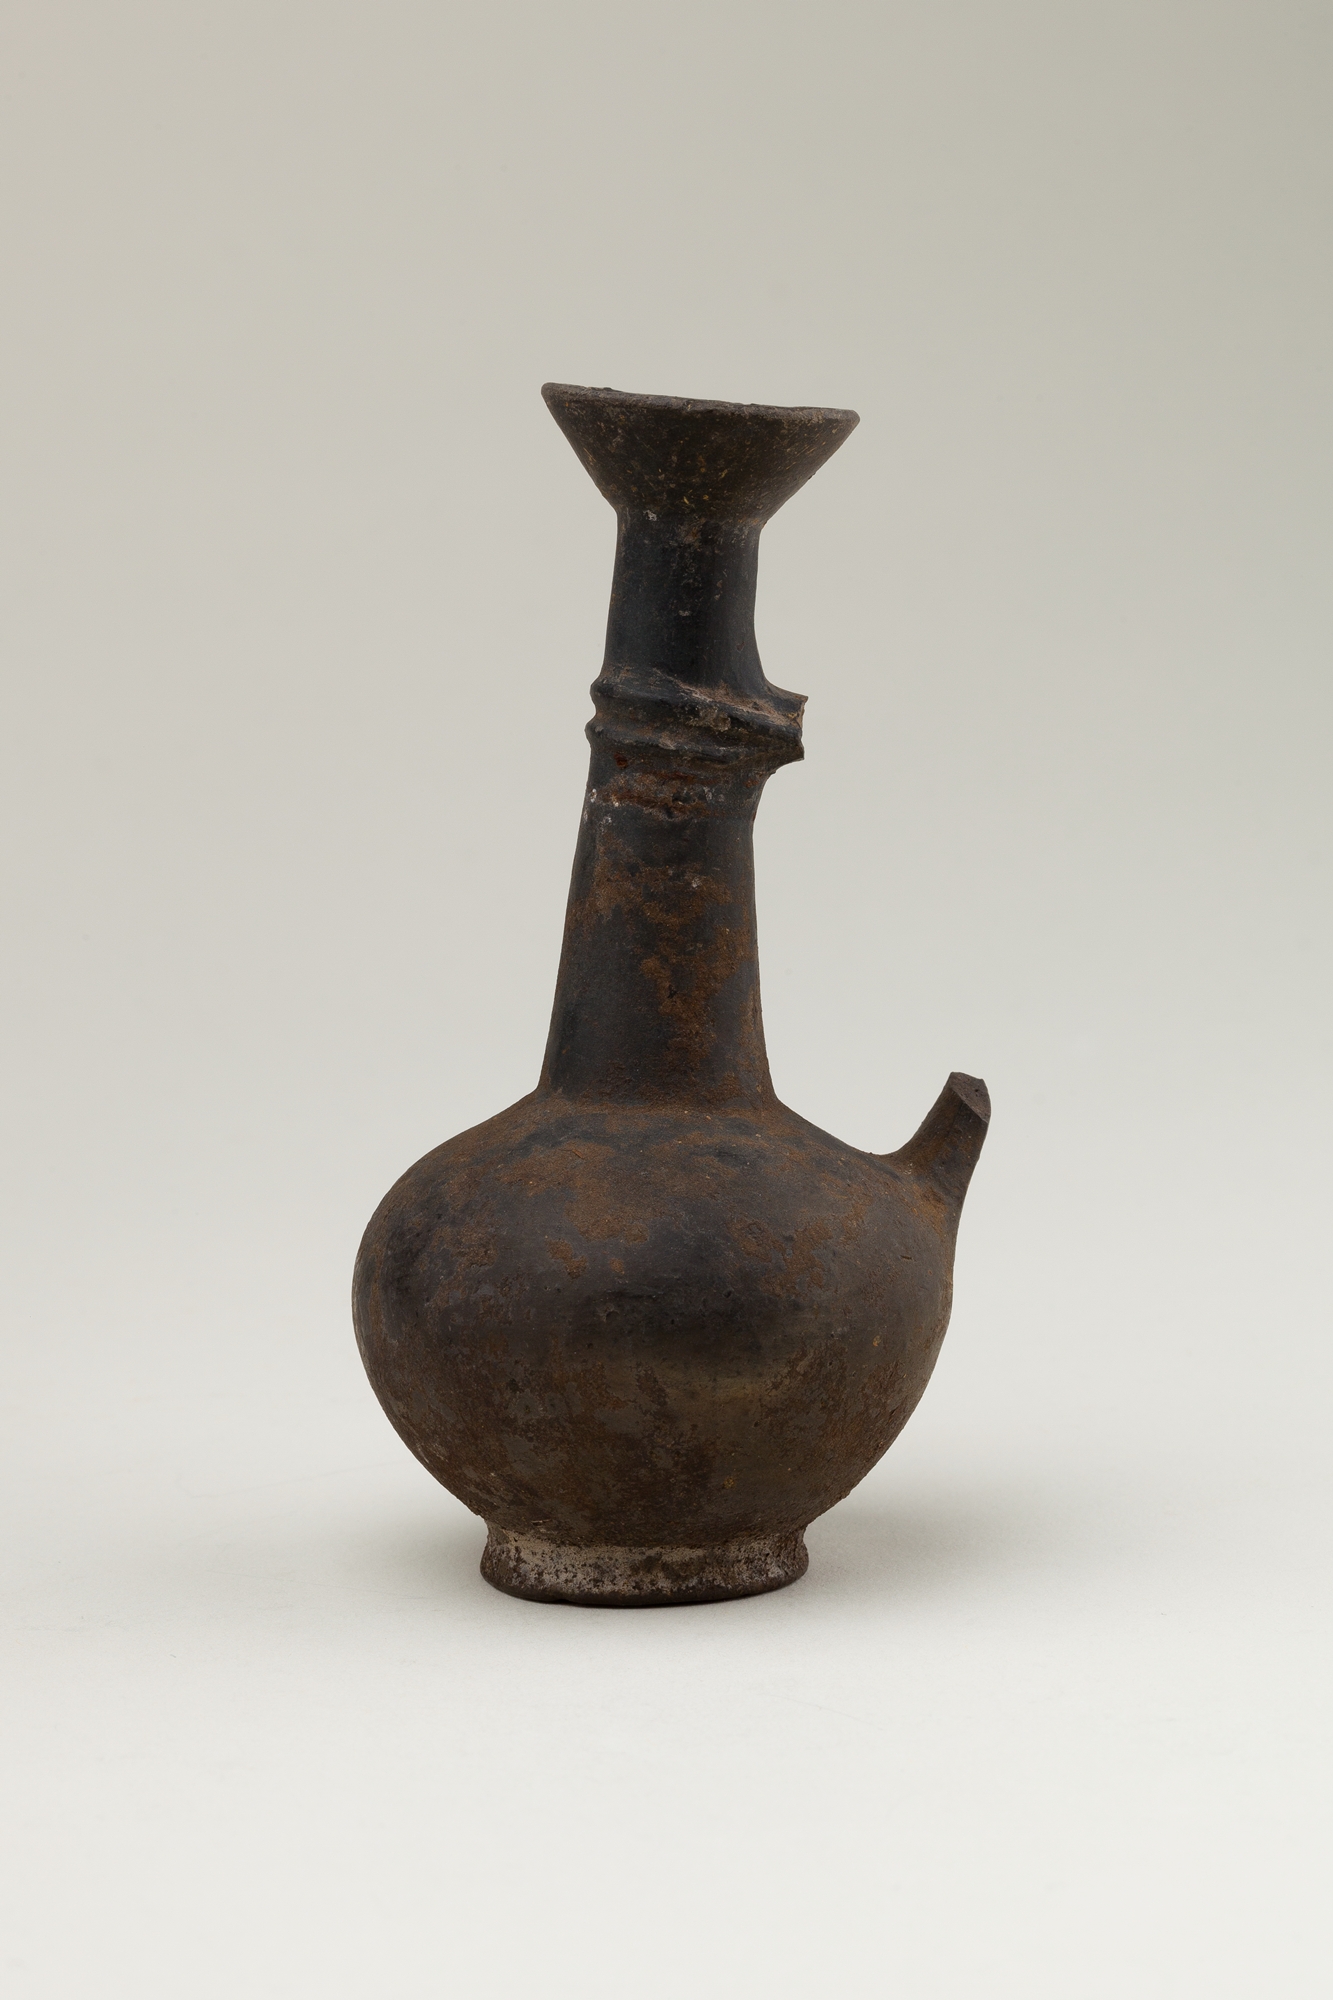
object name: juglet, cypriot, ring base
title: Cypriot Ring Base Juglet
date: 1550-1525 BCE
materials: pottery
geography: egypt